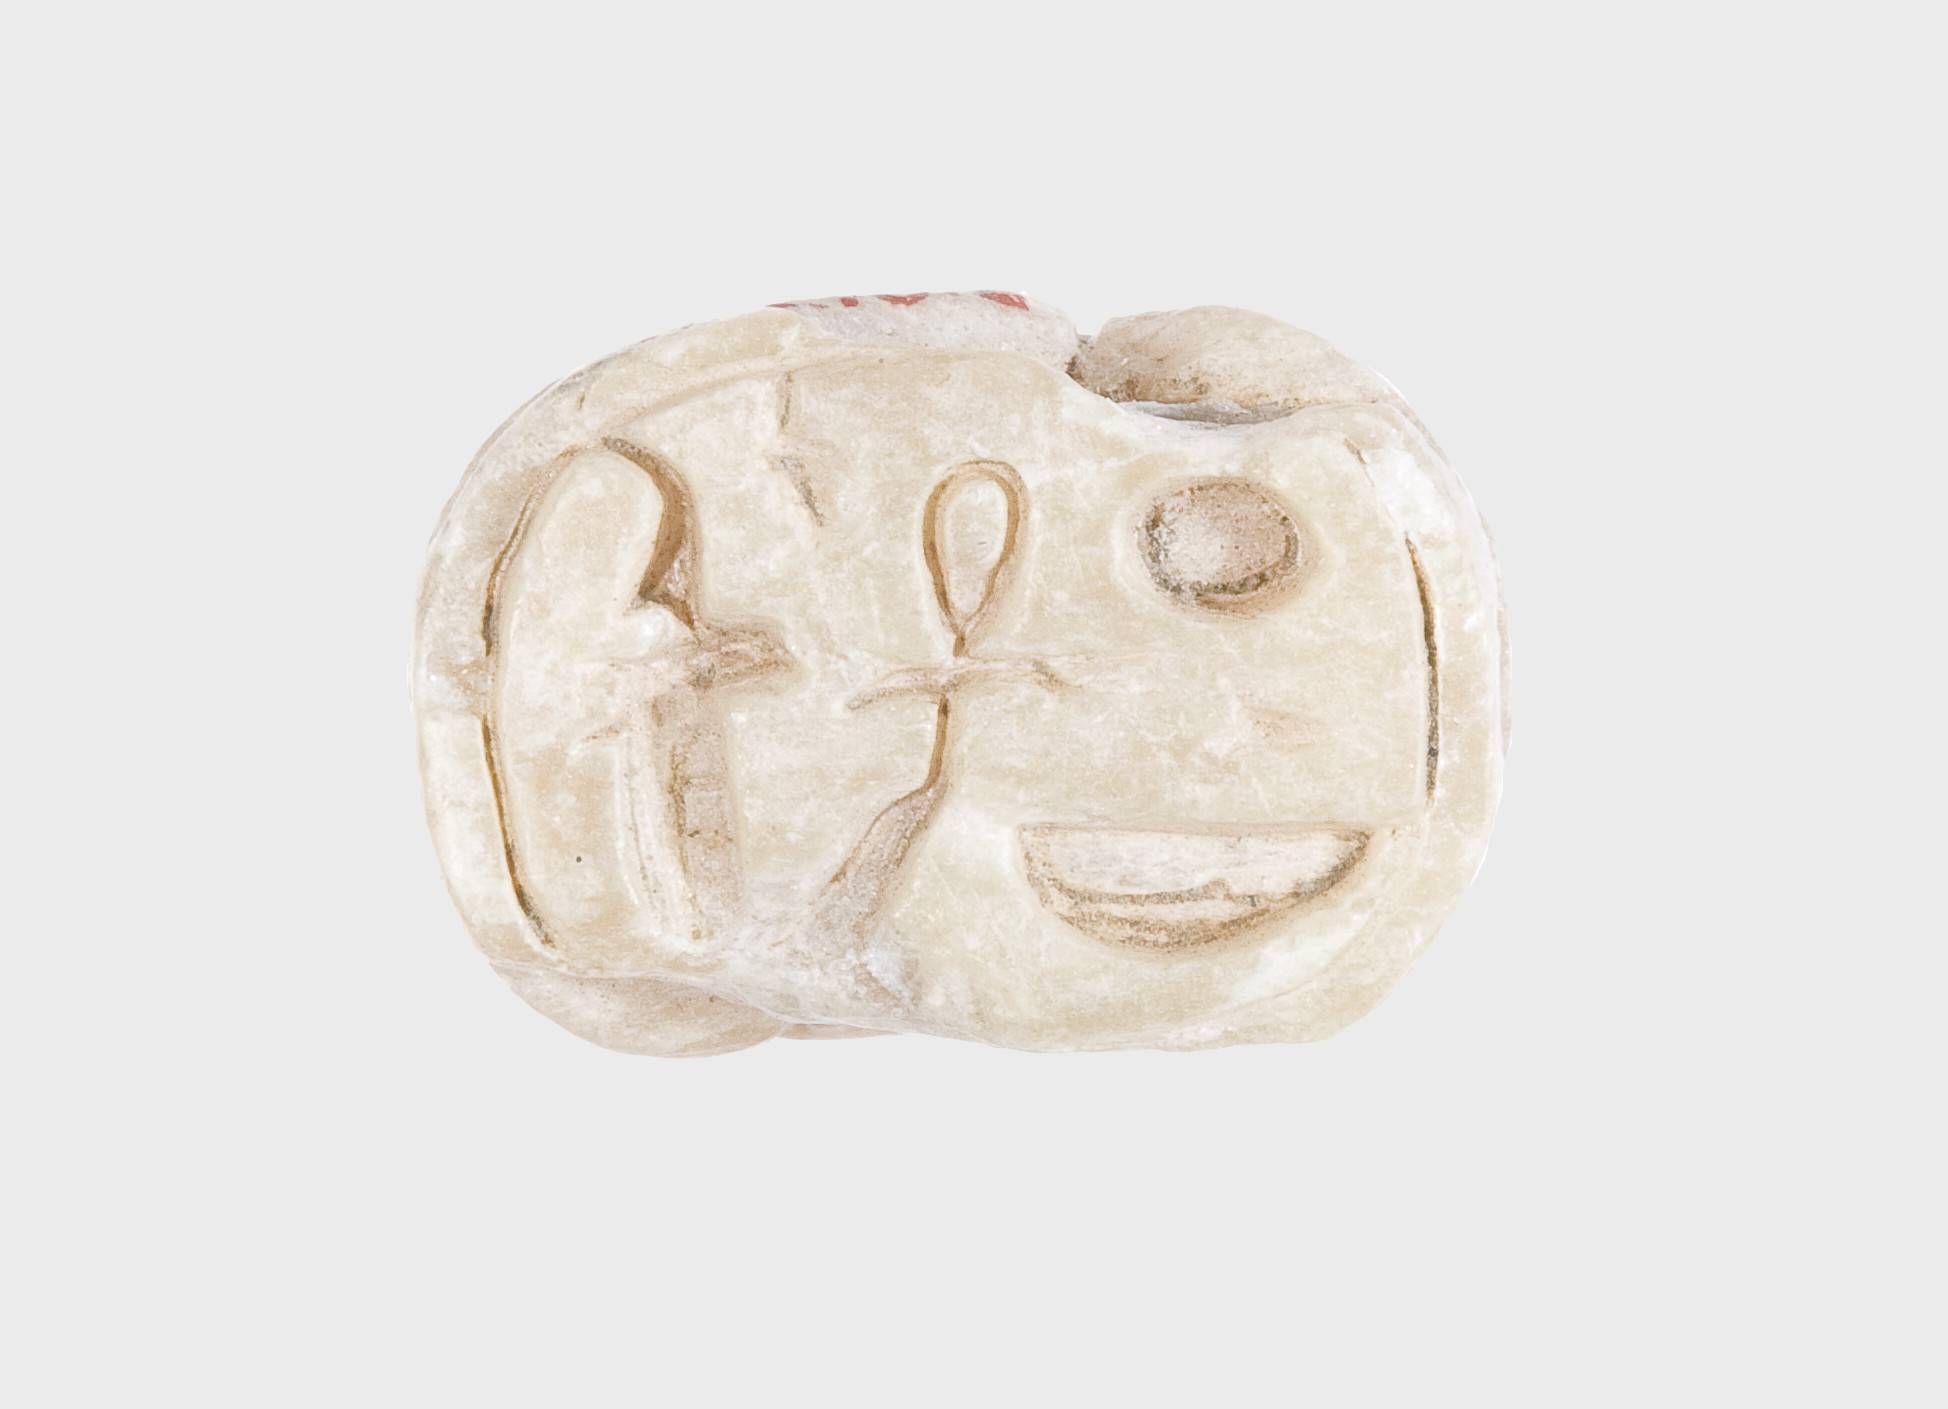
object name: scarab, nebmaatre, amenhotep iii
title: Scarab with the Throne Name of Amenhotep III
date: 1390-1352 BCE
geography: egypt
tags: hieroglyphs,scarabs